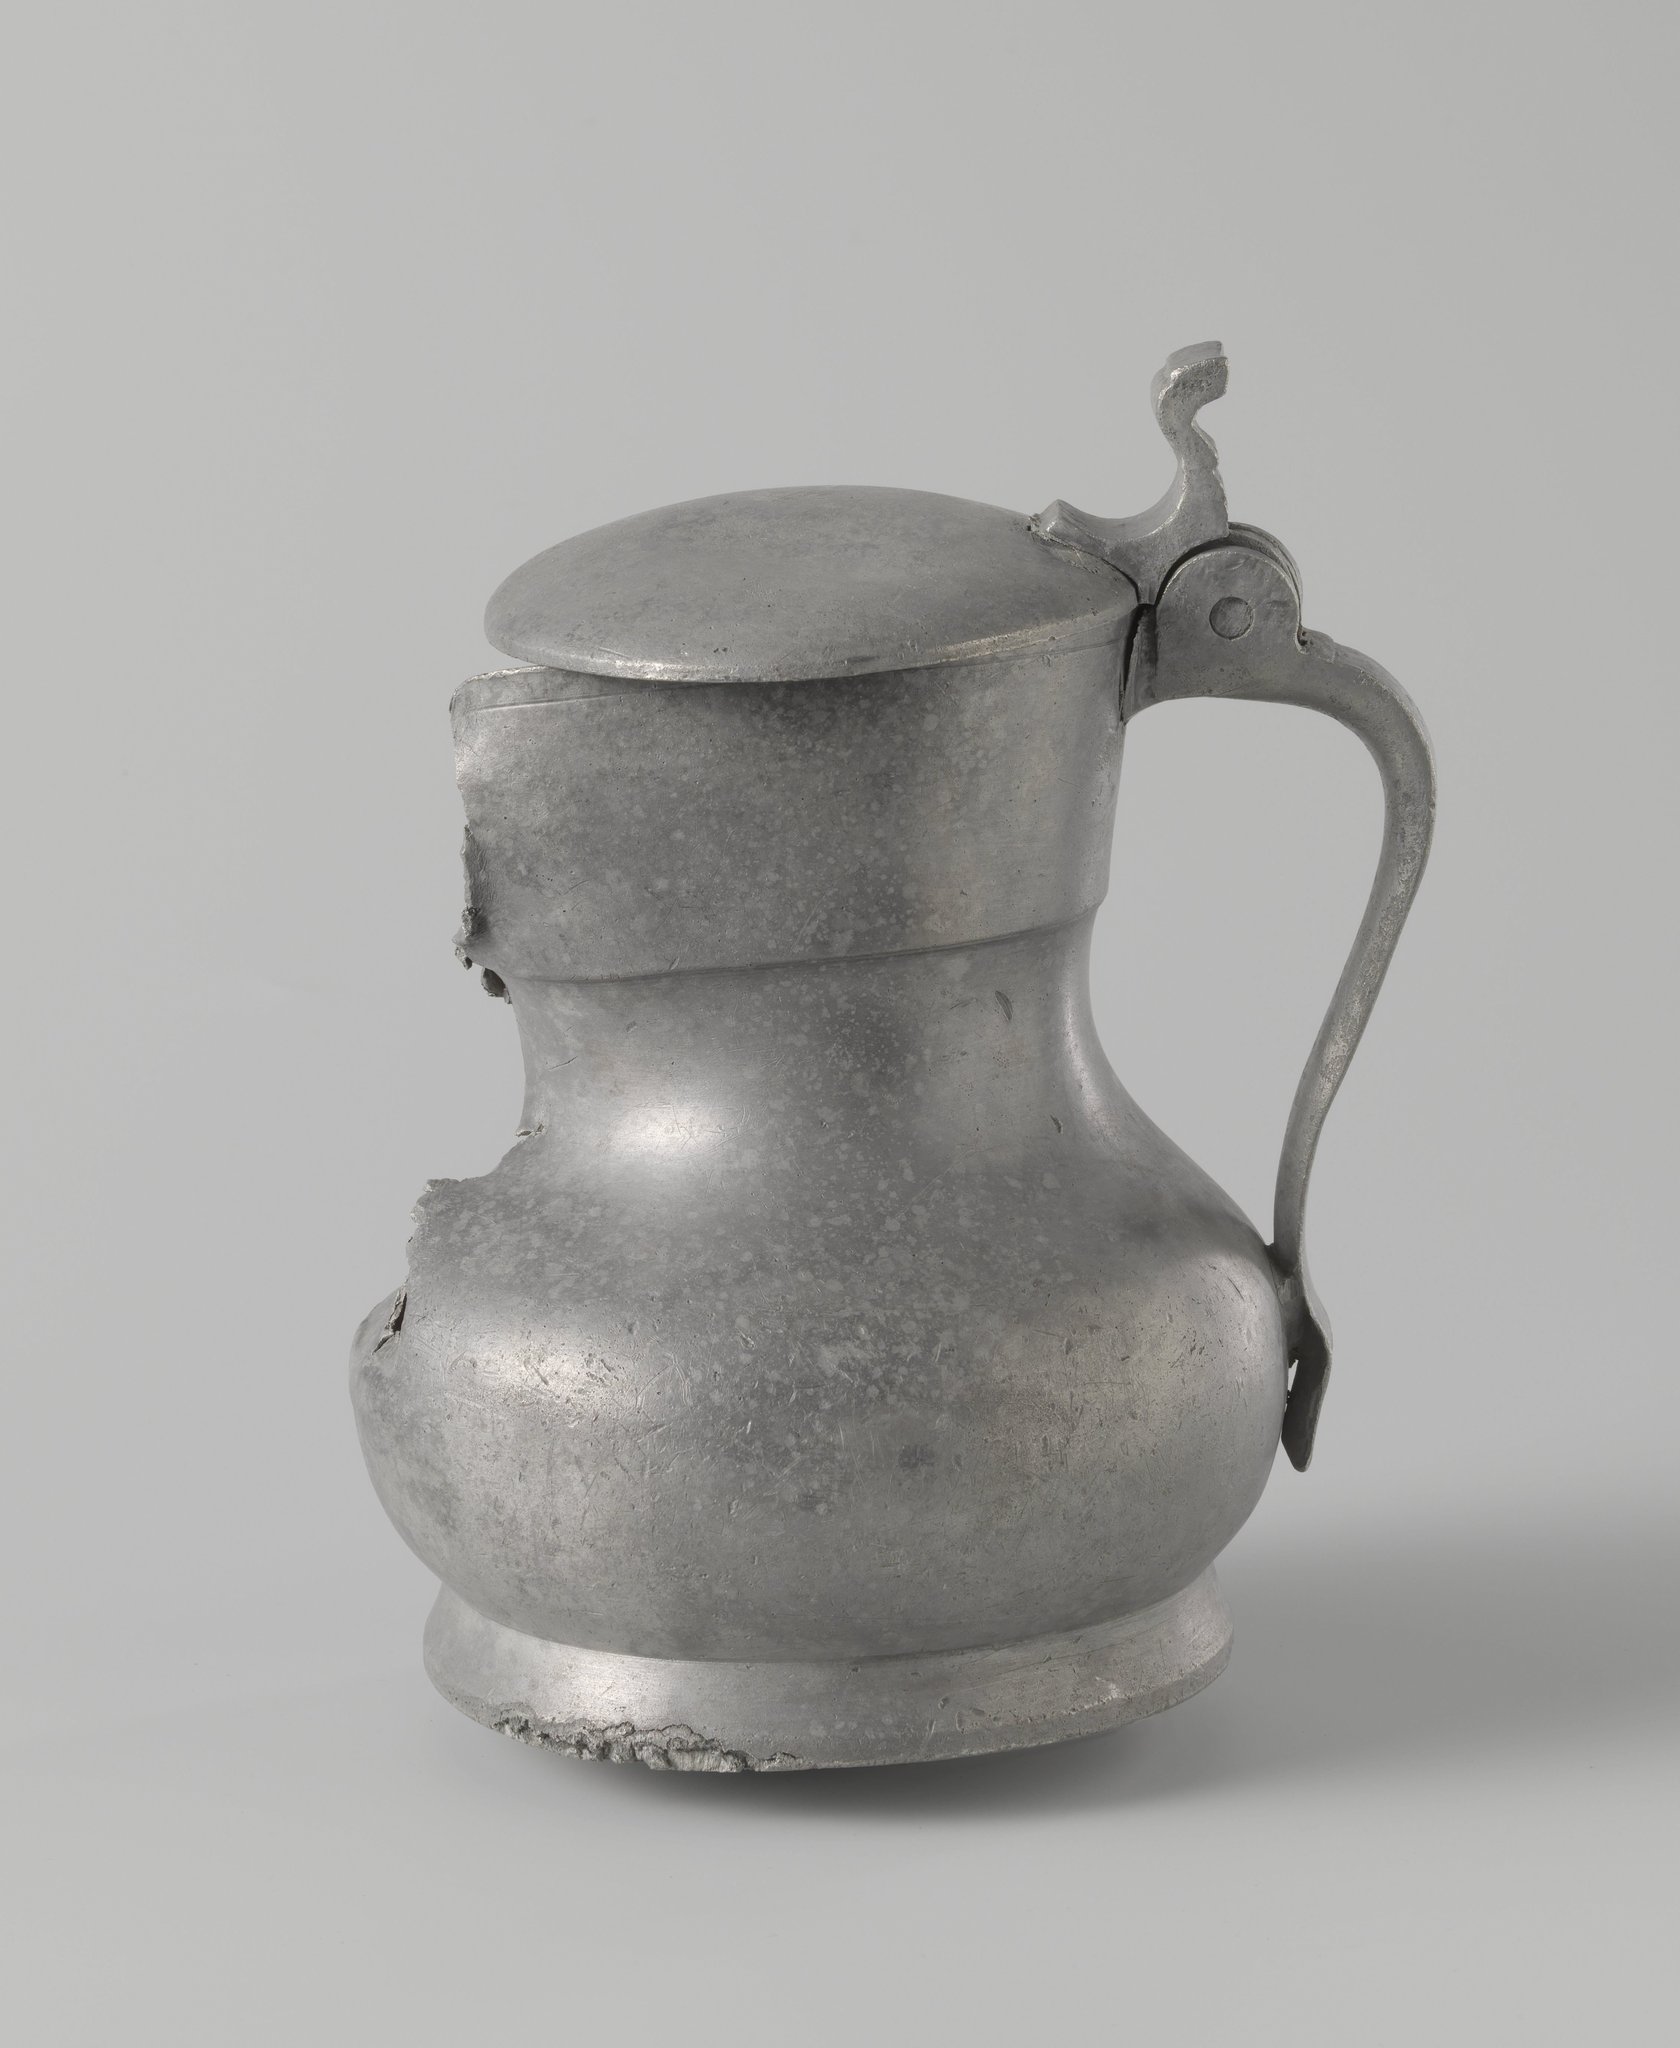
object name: ewer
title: Household effects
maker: Anonymous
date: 1590-1596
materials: tin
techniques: casting, welding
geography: amsterdam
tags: willem barendsz., amsterdam, jacob van heemskerck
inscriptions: mark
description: Among the remnants from the ‘Safe House’ were many utilitarian household objects, such as plates, cutlery and brushes. The taps originally were attached to wooden barrels containing water or wine. The ‘spike candleholders’, which could be hammered into a wooden beam, were particularly convenient.